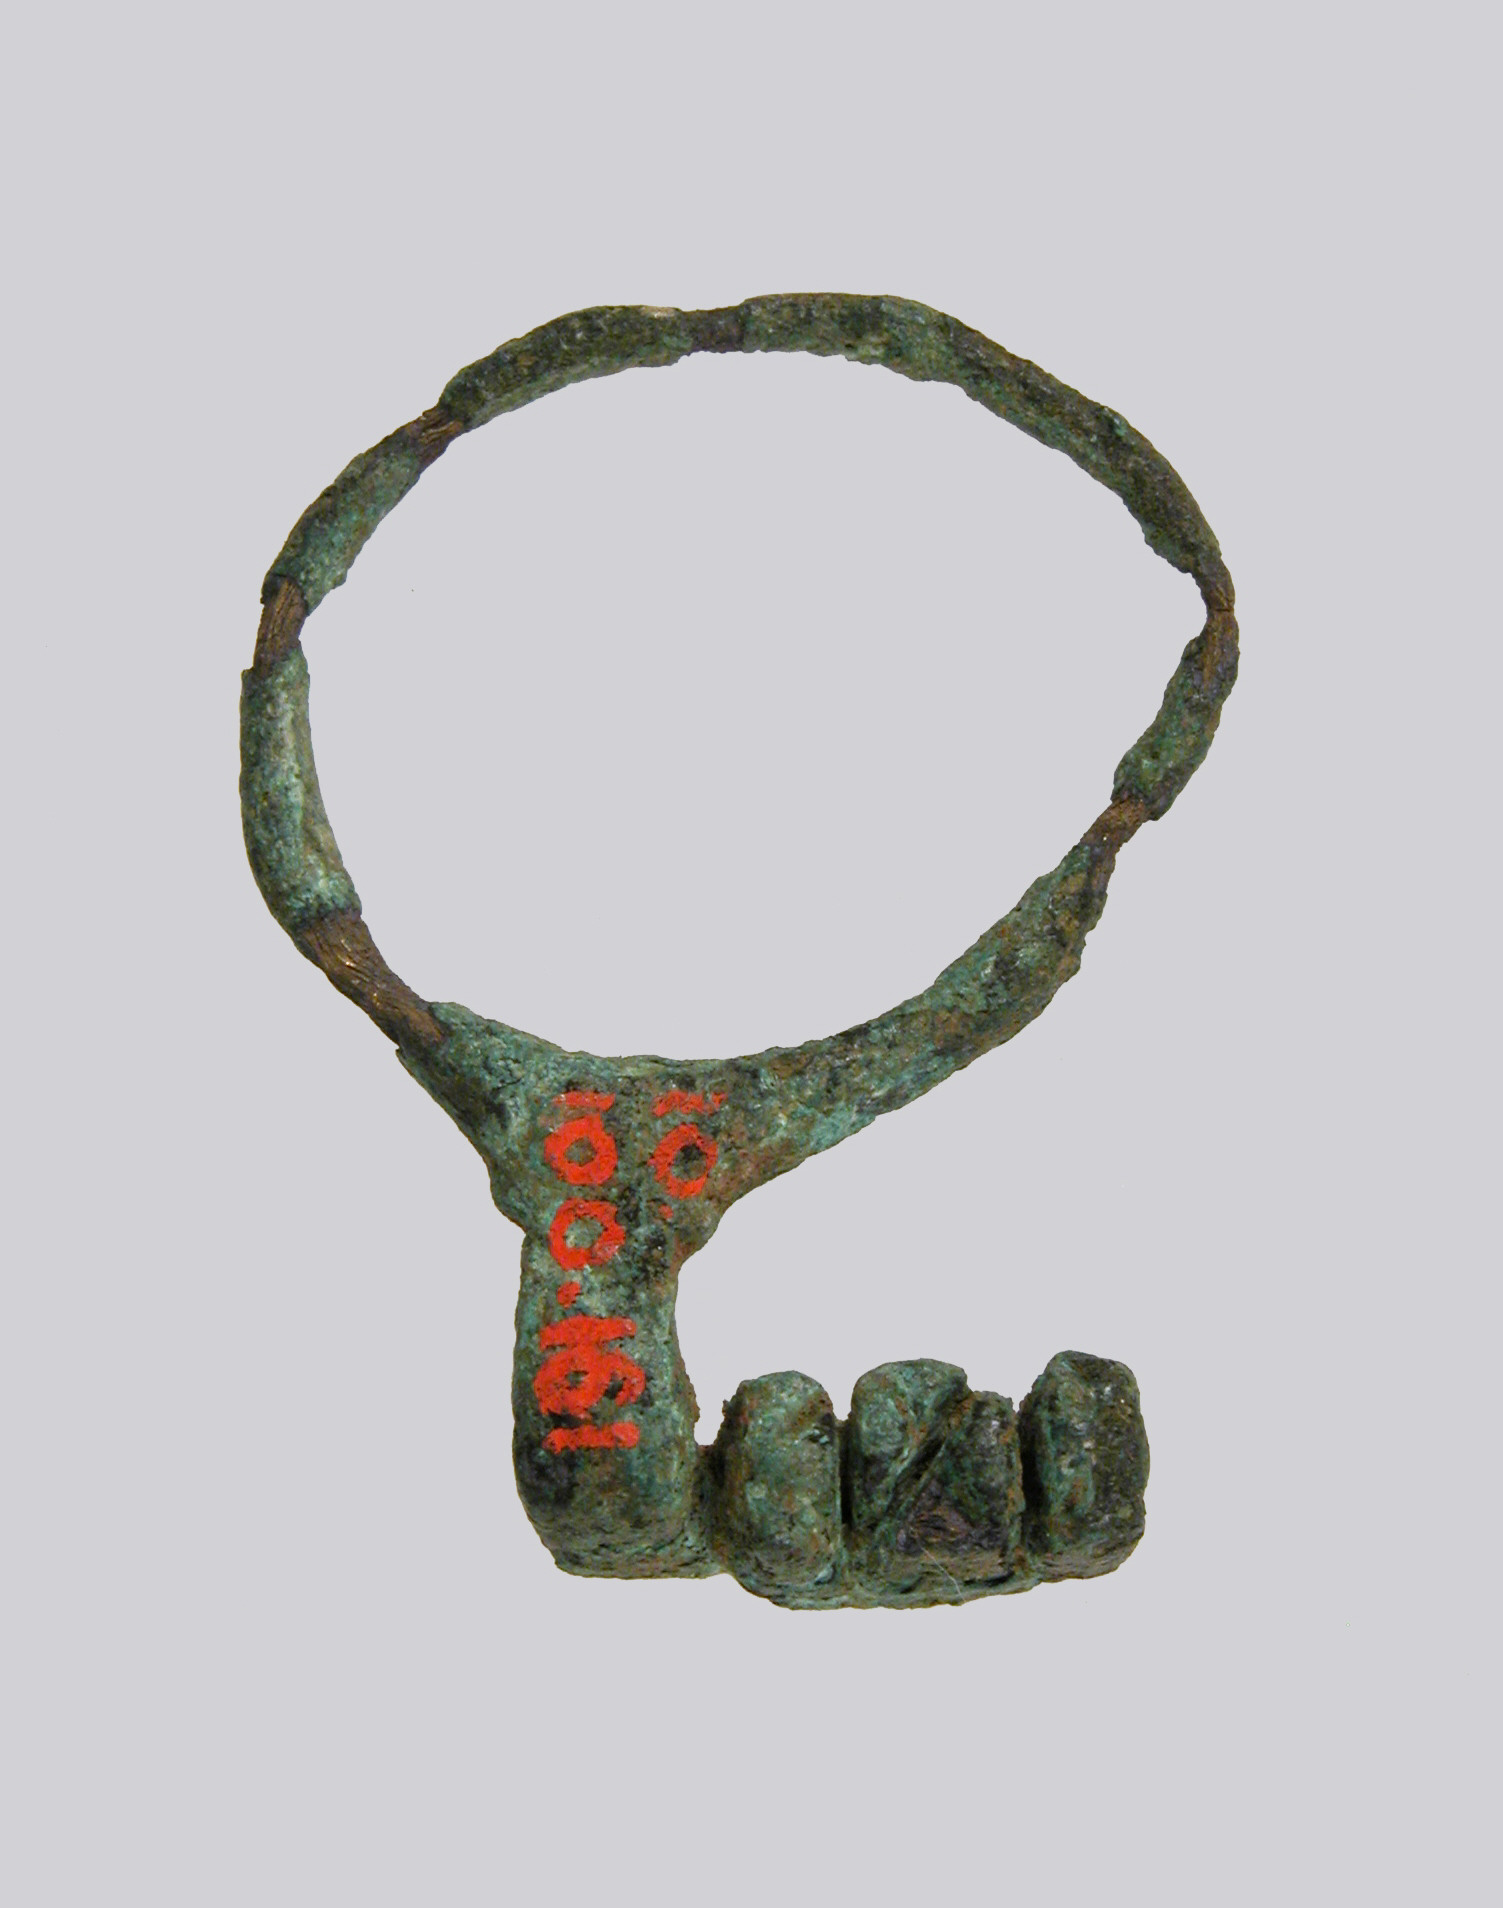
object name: key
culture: roman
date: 1-300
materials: copper alloy, iron